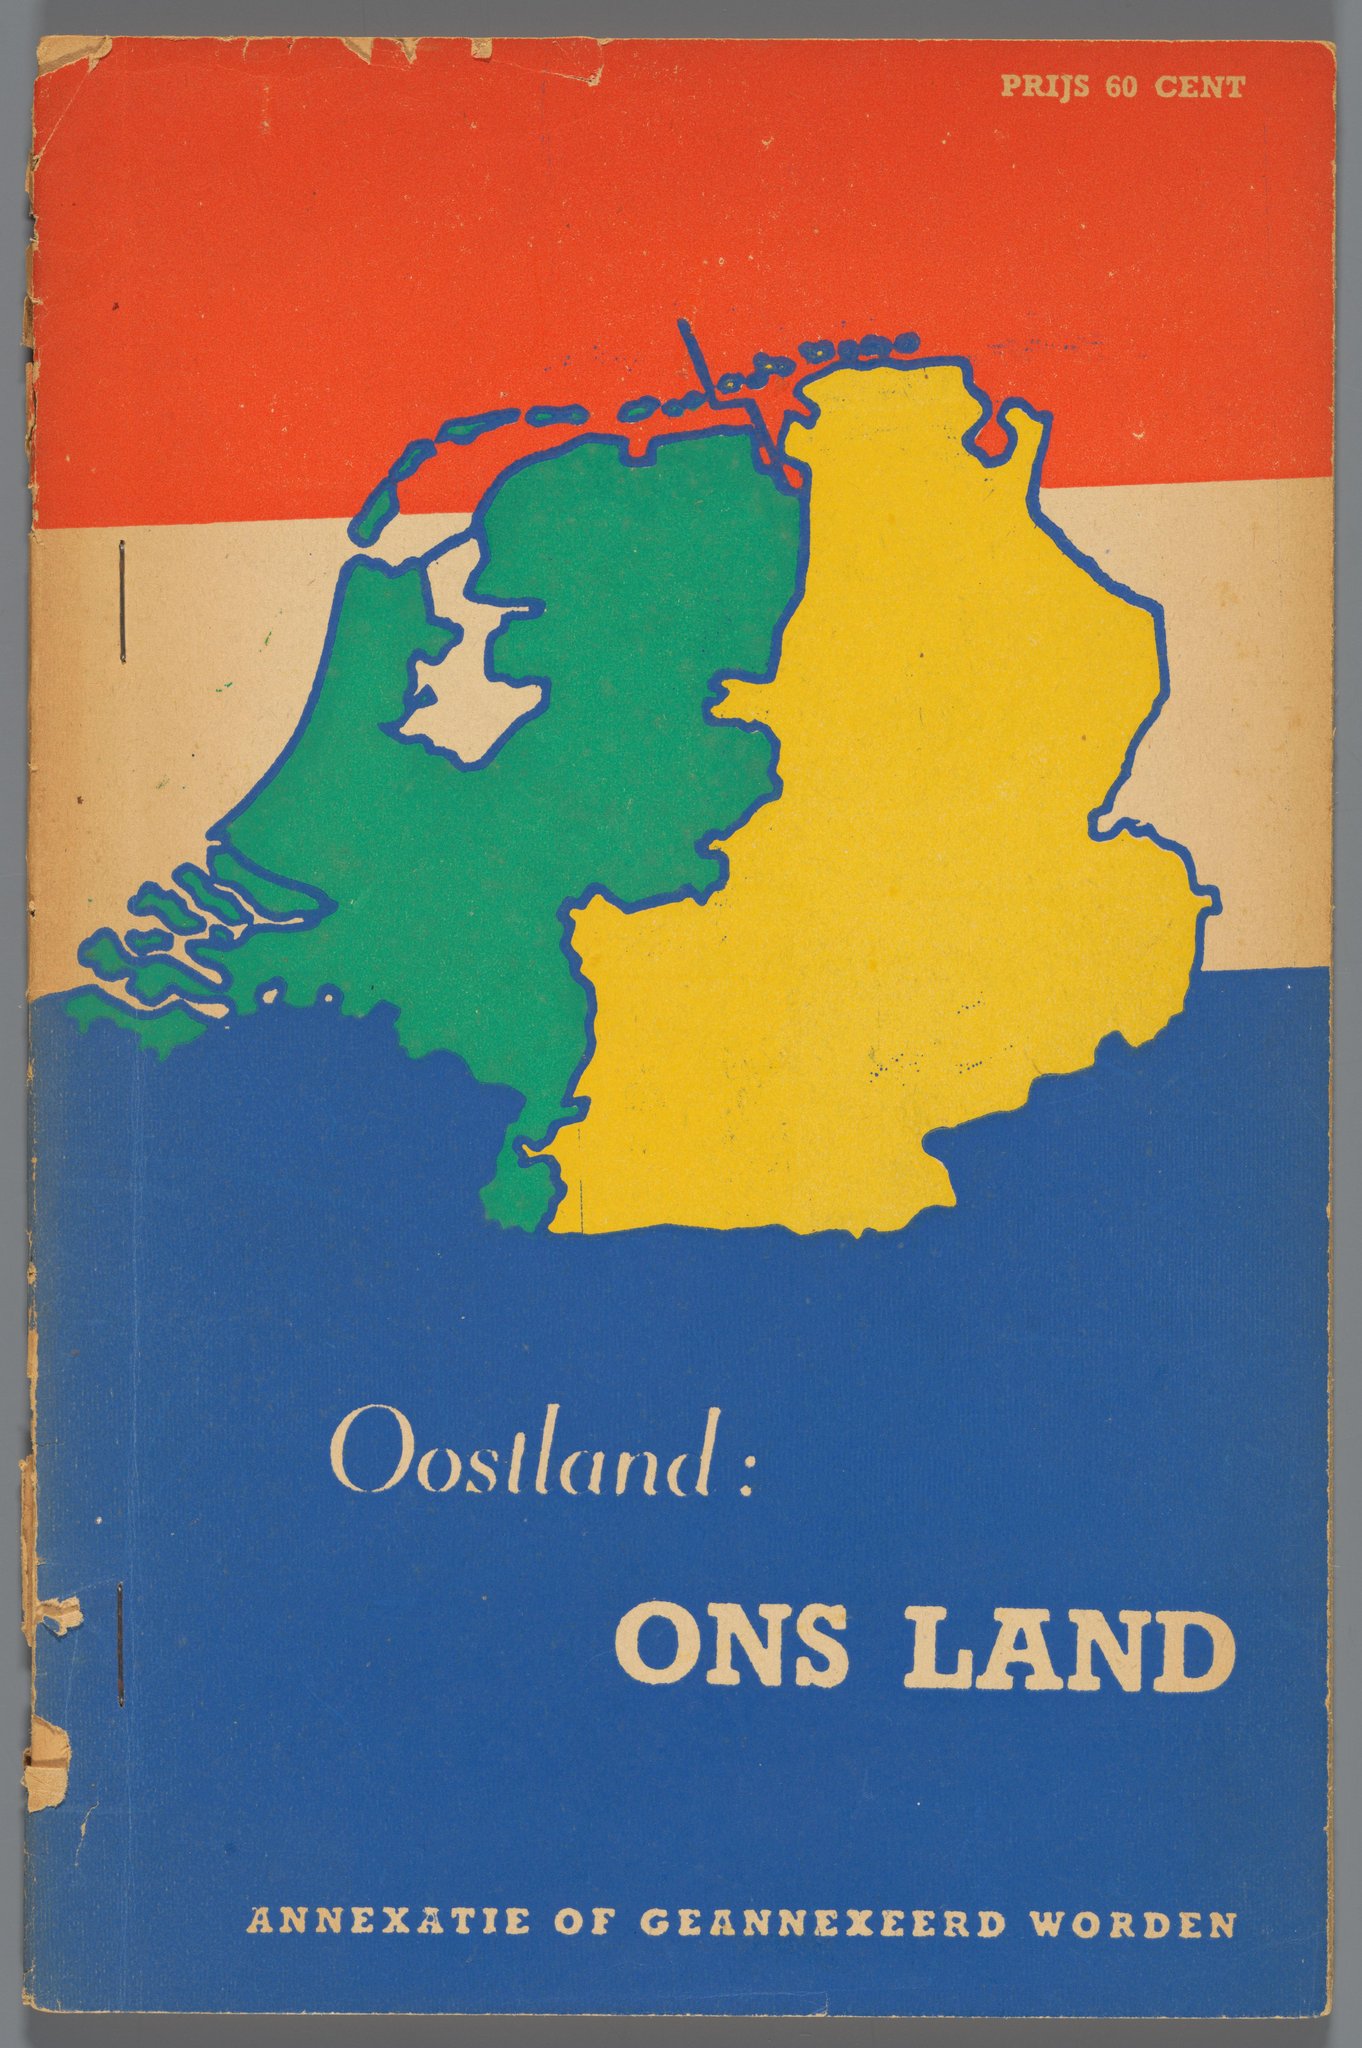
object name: brochure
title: Oostland, ons land. Annexatie of geannexeerd worden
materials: metal, paper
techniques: printing, stapling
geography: amsterdam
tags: maps of separate countries or regions, netherlands, germany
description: Brochure met 28 genummerde pagina's. Omslag met op de voorkaft Nederland in groen en een deel van Duitsland in geel op een achtergrond van een Nederlandse vlag. Tweede druk, heruitgave van 1943.